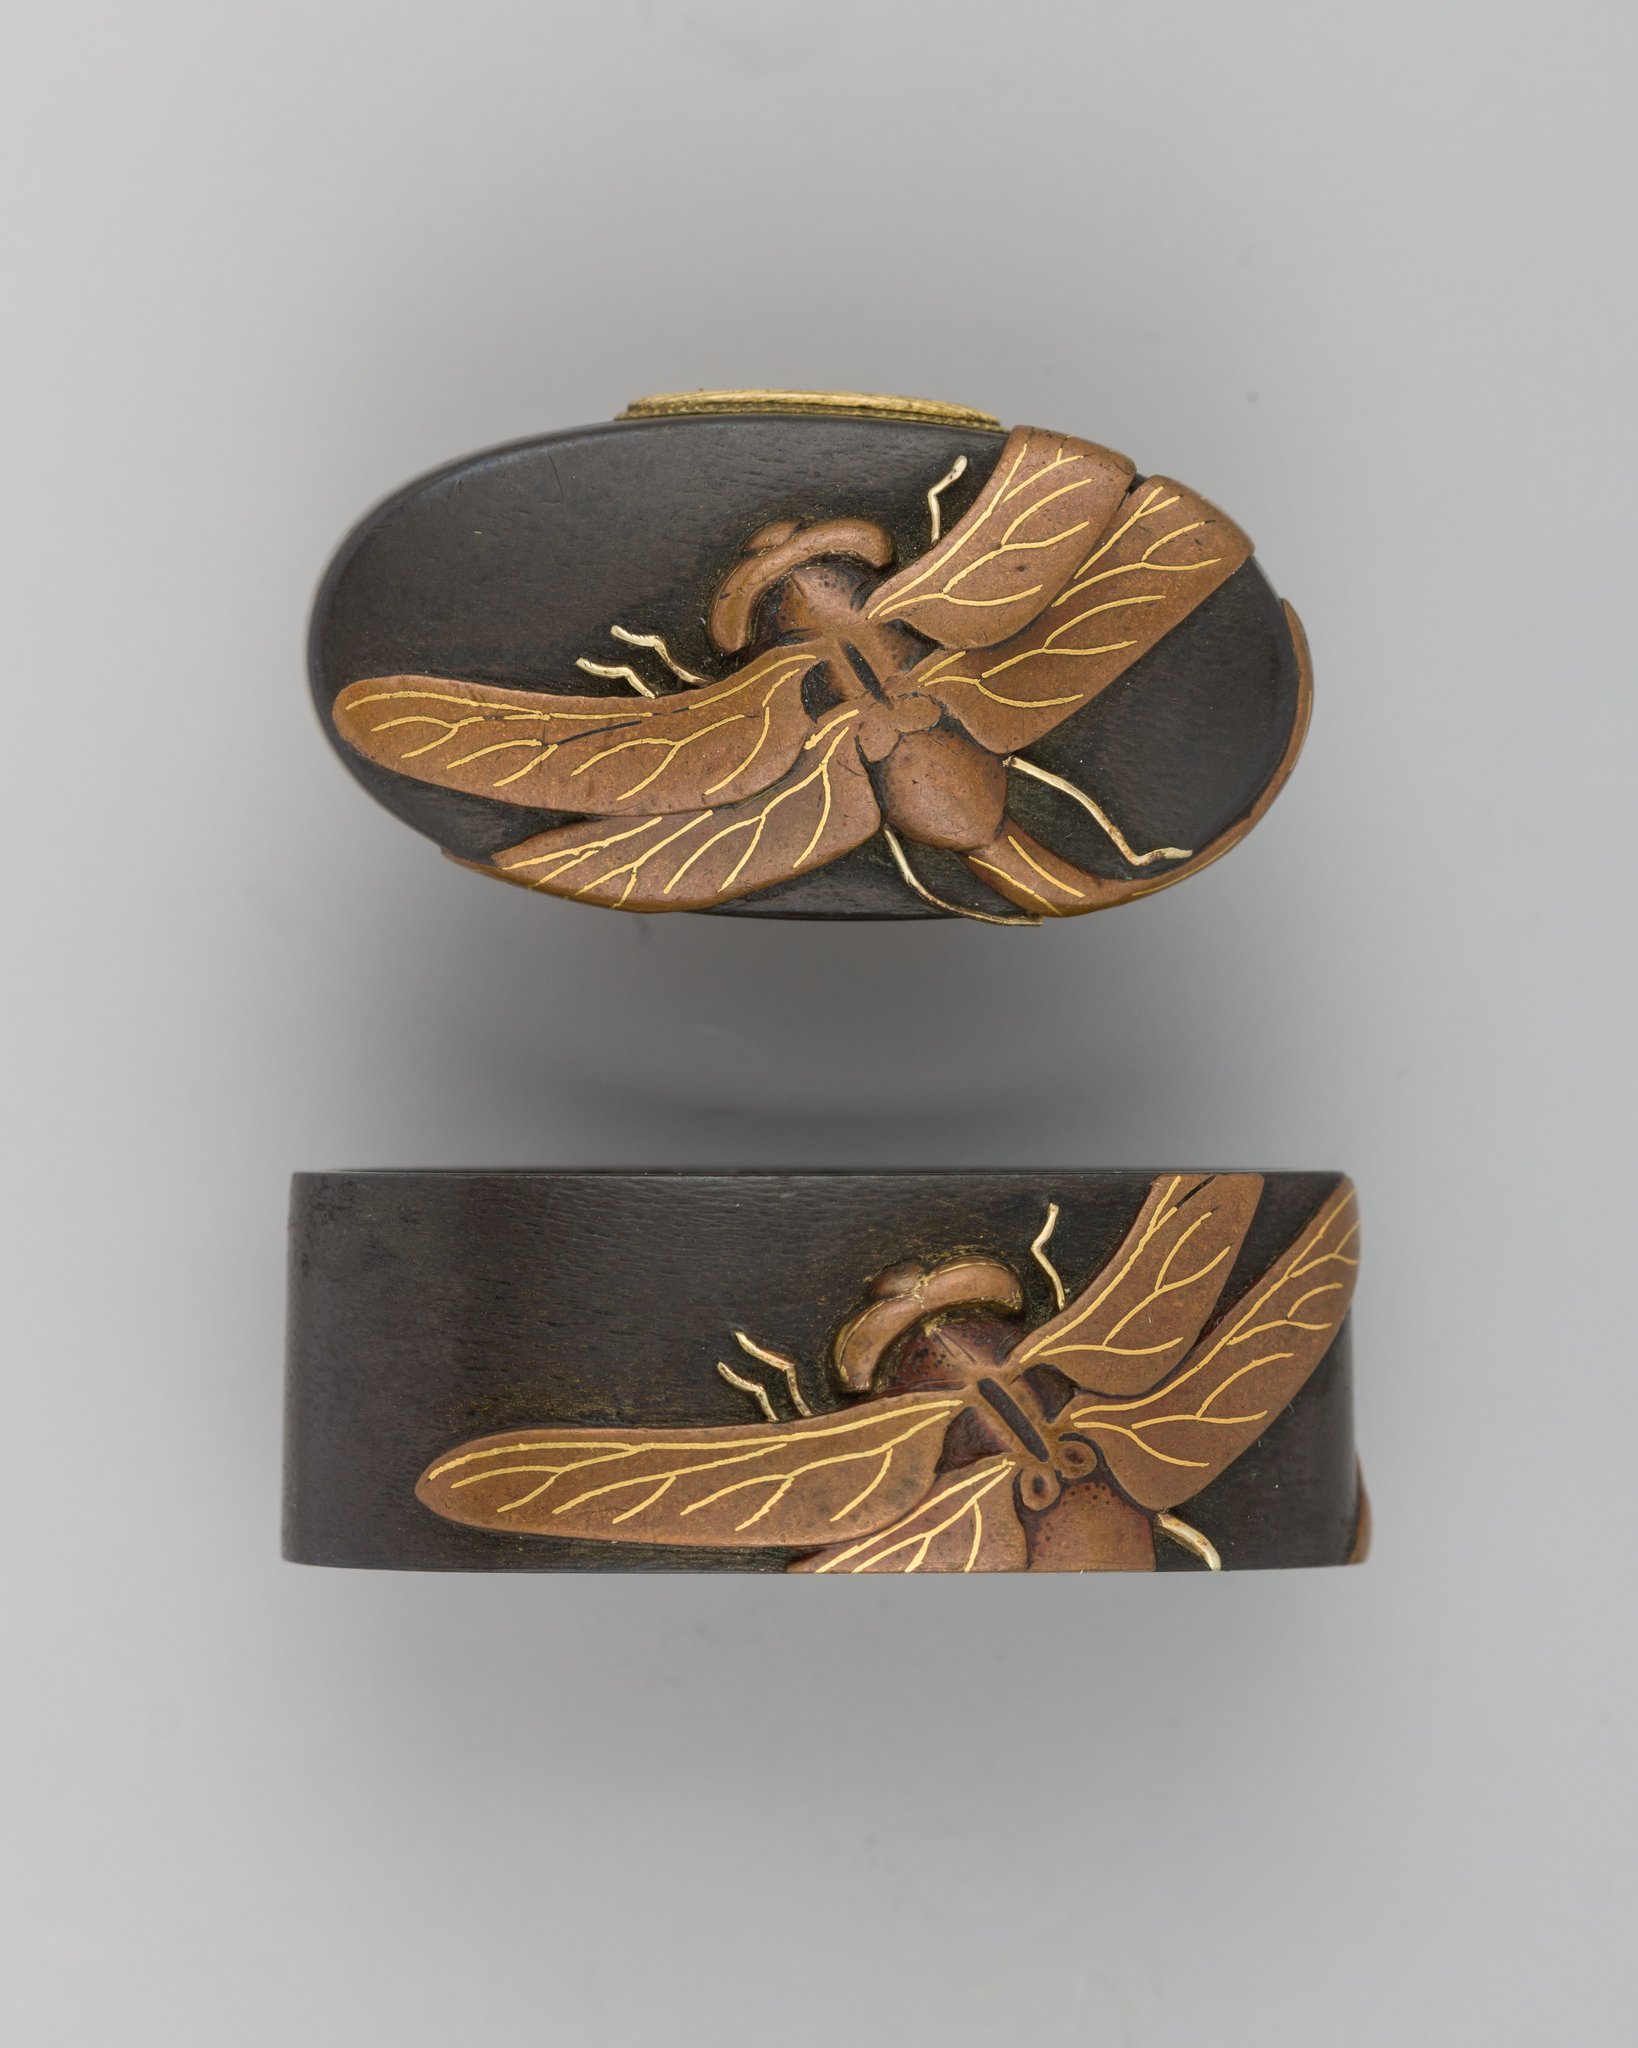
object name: sword hilt collar and pommel fuchigashira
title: Sword-Hilt Collar and Pommel (Fuchigashira)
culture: japanese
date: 1701-1800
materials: copper, silver alloy, gold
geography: japan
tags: dragonflies